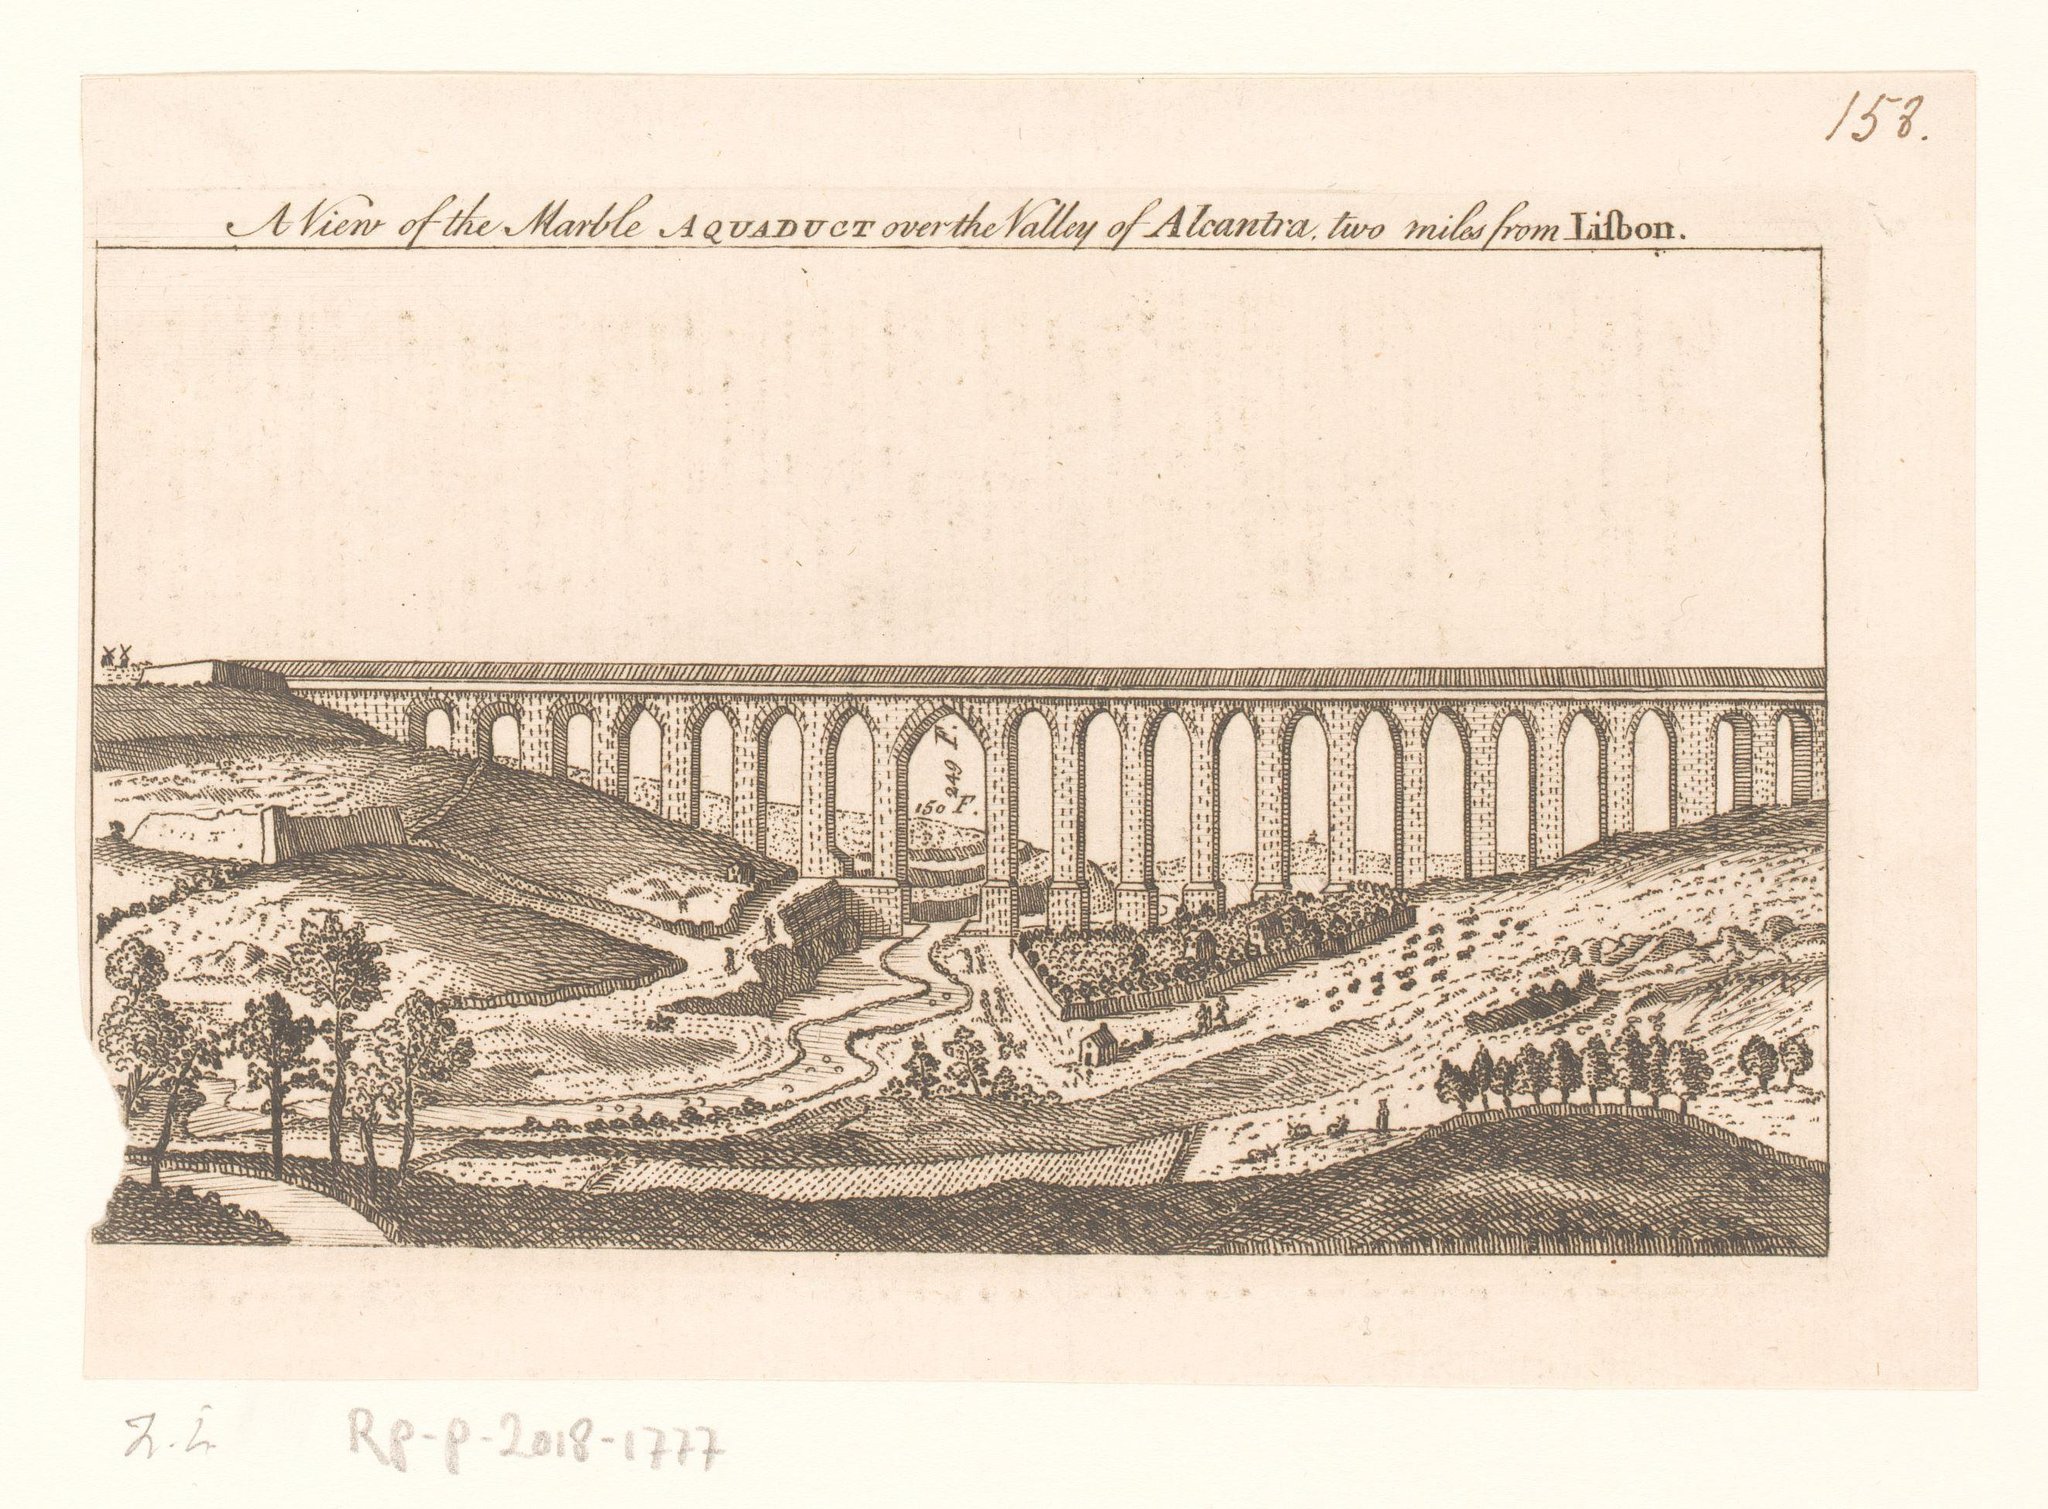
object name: print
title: Gezicht op het Águas Livres aquaduct, bij Lissabon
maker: Anonymous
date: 1749-1799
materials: paper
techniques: engraving, etching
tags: landscape with bridge, viaduct or aqueduct, aqueduct (~ water supply)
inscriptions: collector's mark: Lugt 2228